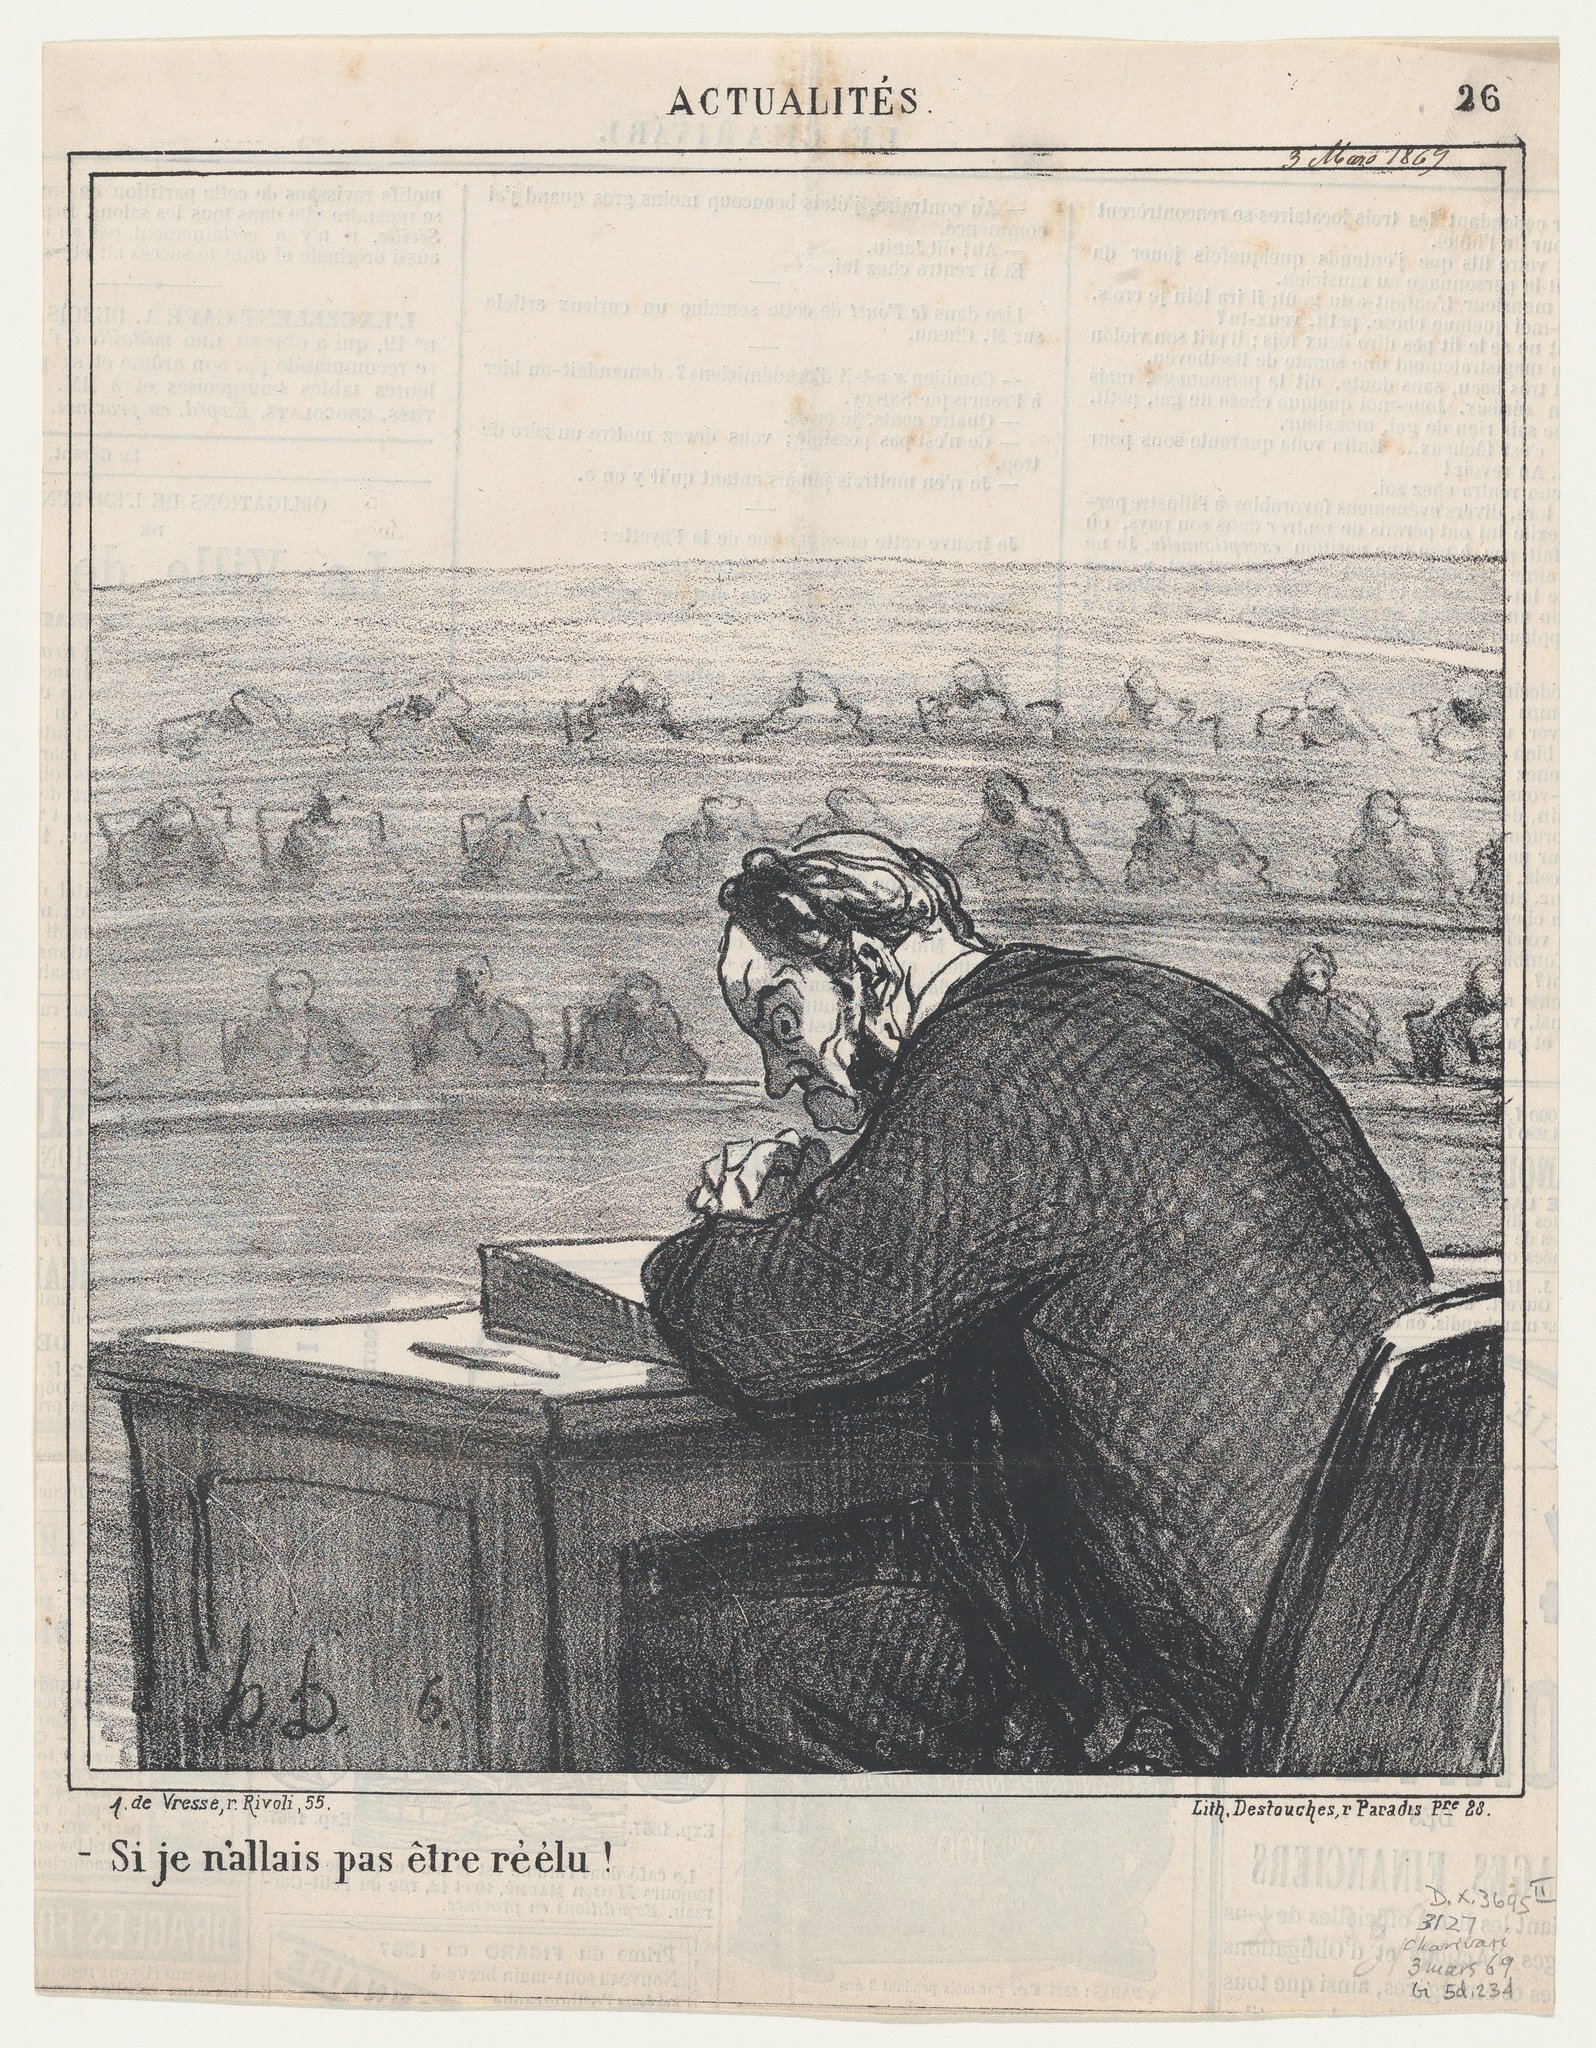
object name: print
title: What if I don't get re-elected!, from 'News of the day,' published in Le Charivari, March 3, 1869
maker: honoré daumier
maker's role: artist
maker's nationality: french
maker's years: 1808-1879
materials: ink, paper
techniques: lithograph, pen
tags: satire,men